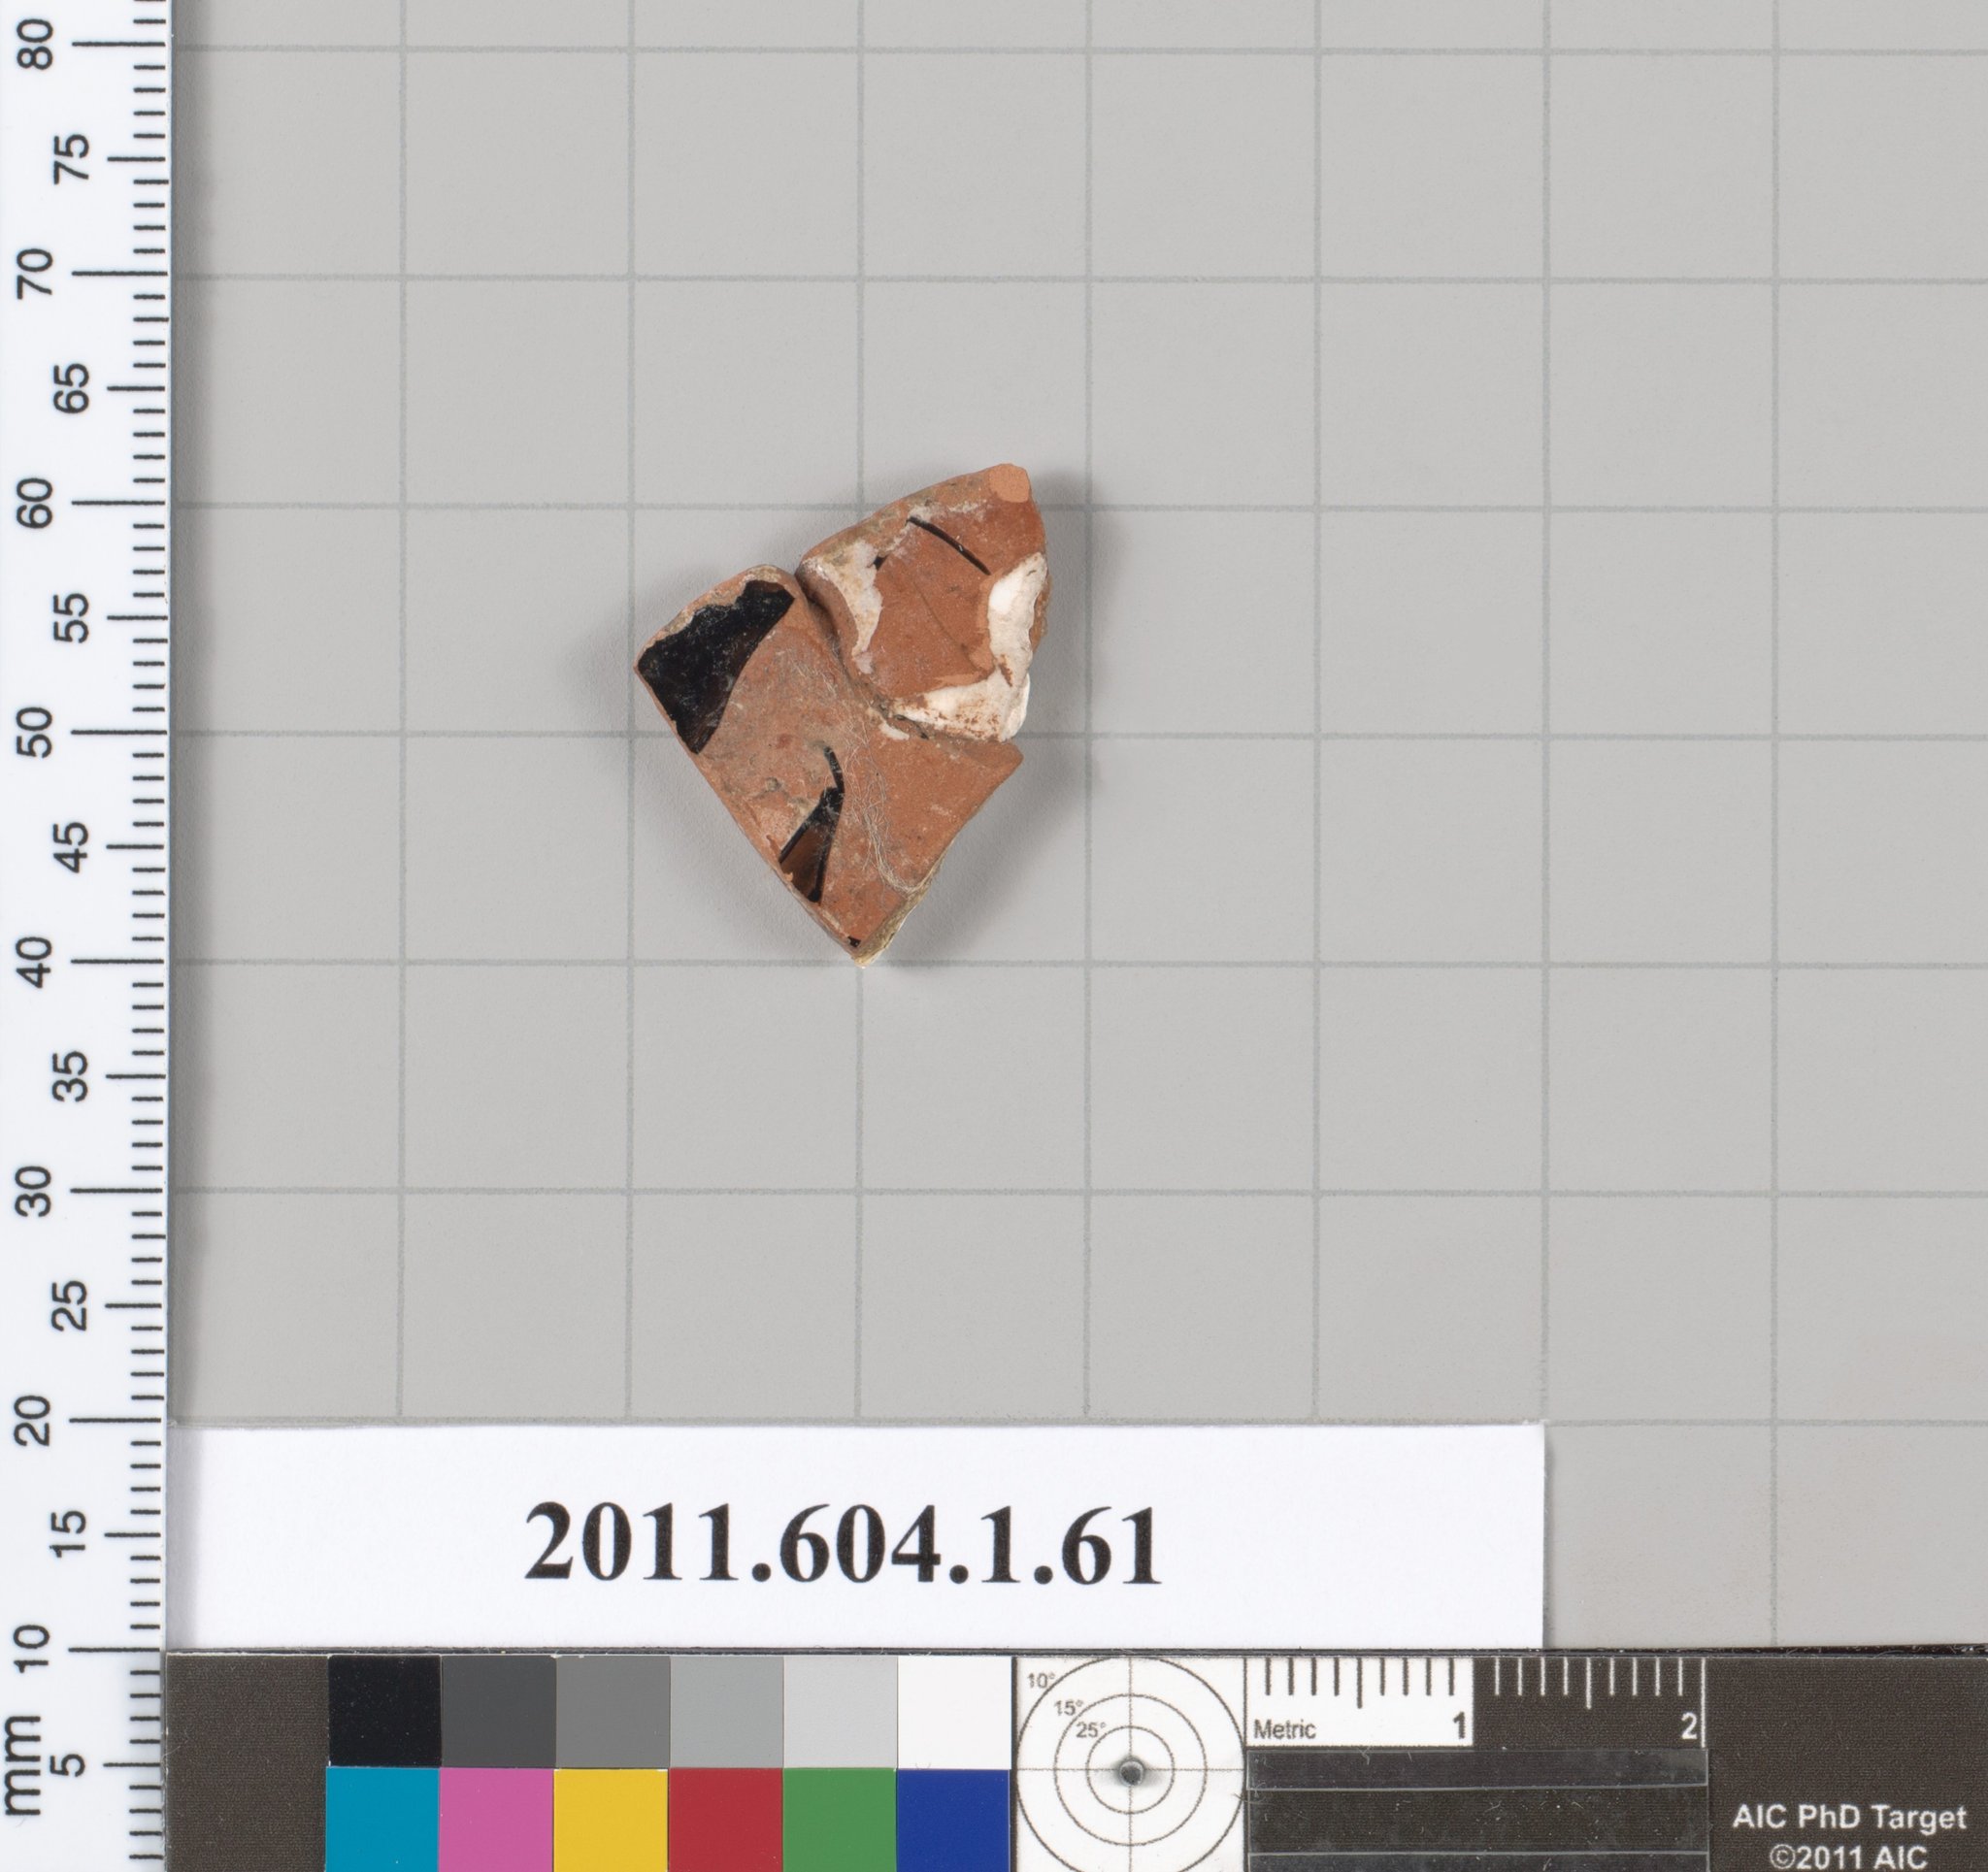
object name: kylix fragment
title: Terracotta fragment of a kylix (drinking cup)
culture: greek, attic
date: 500-401 BCE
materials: terracotta